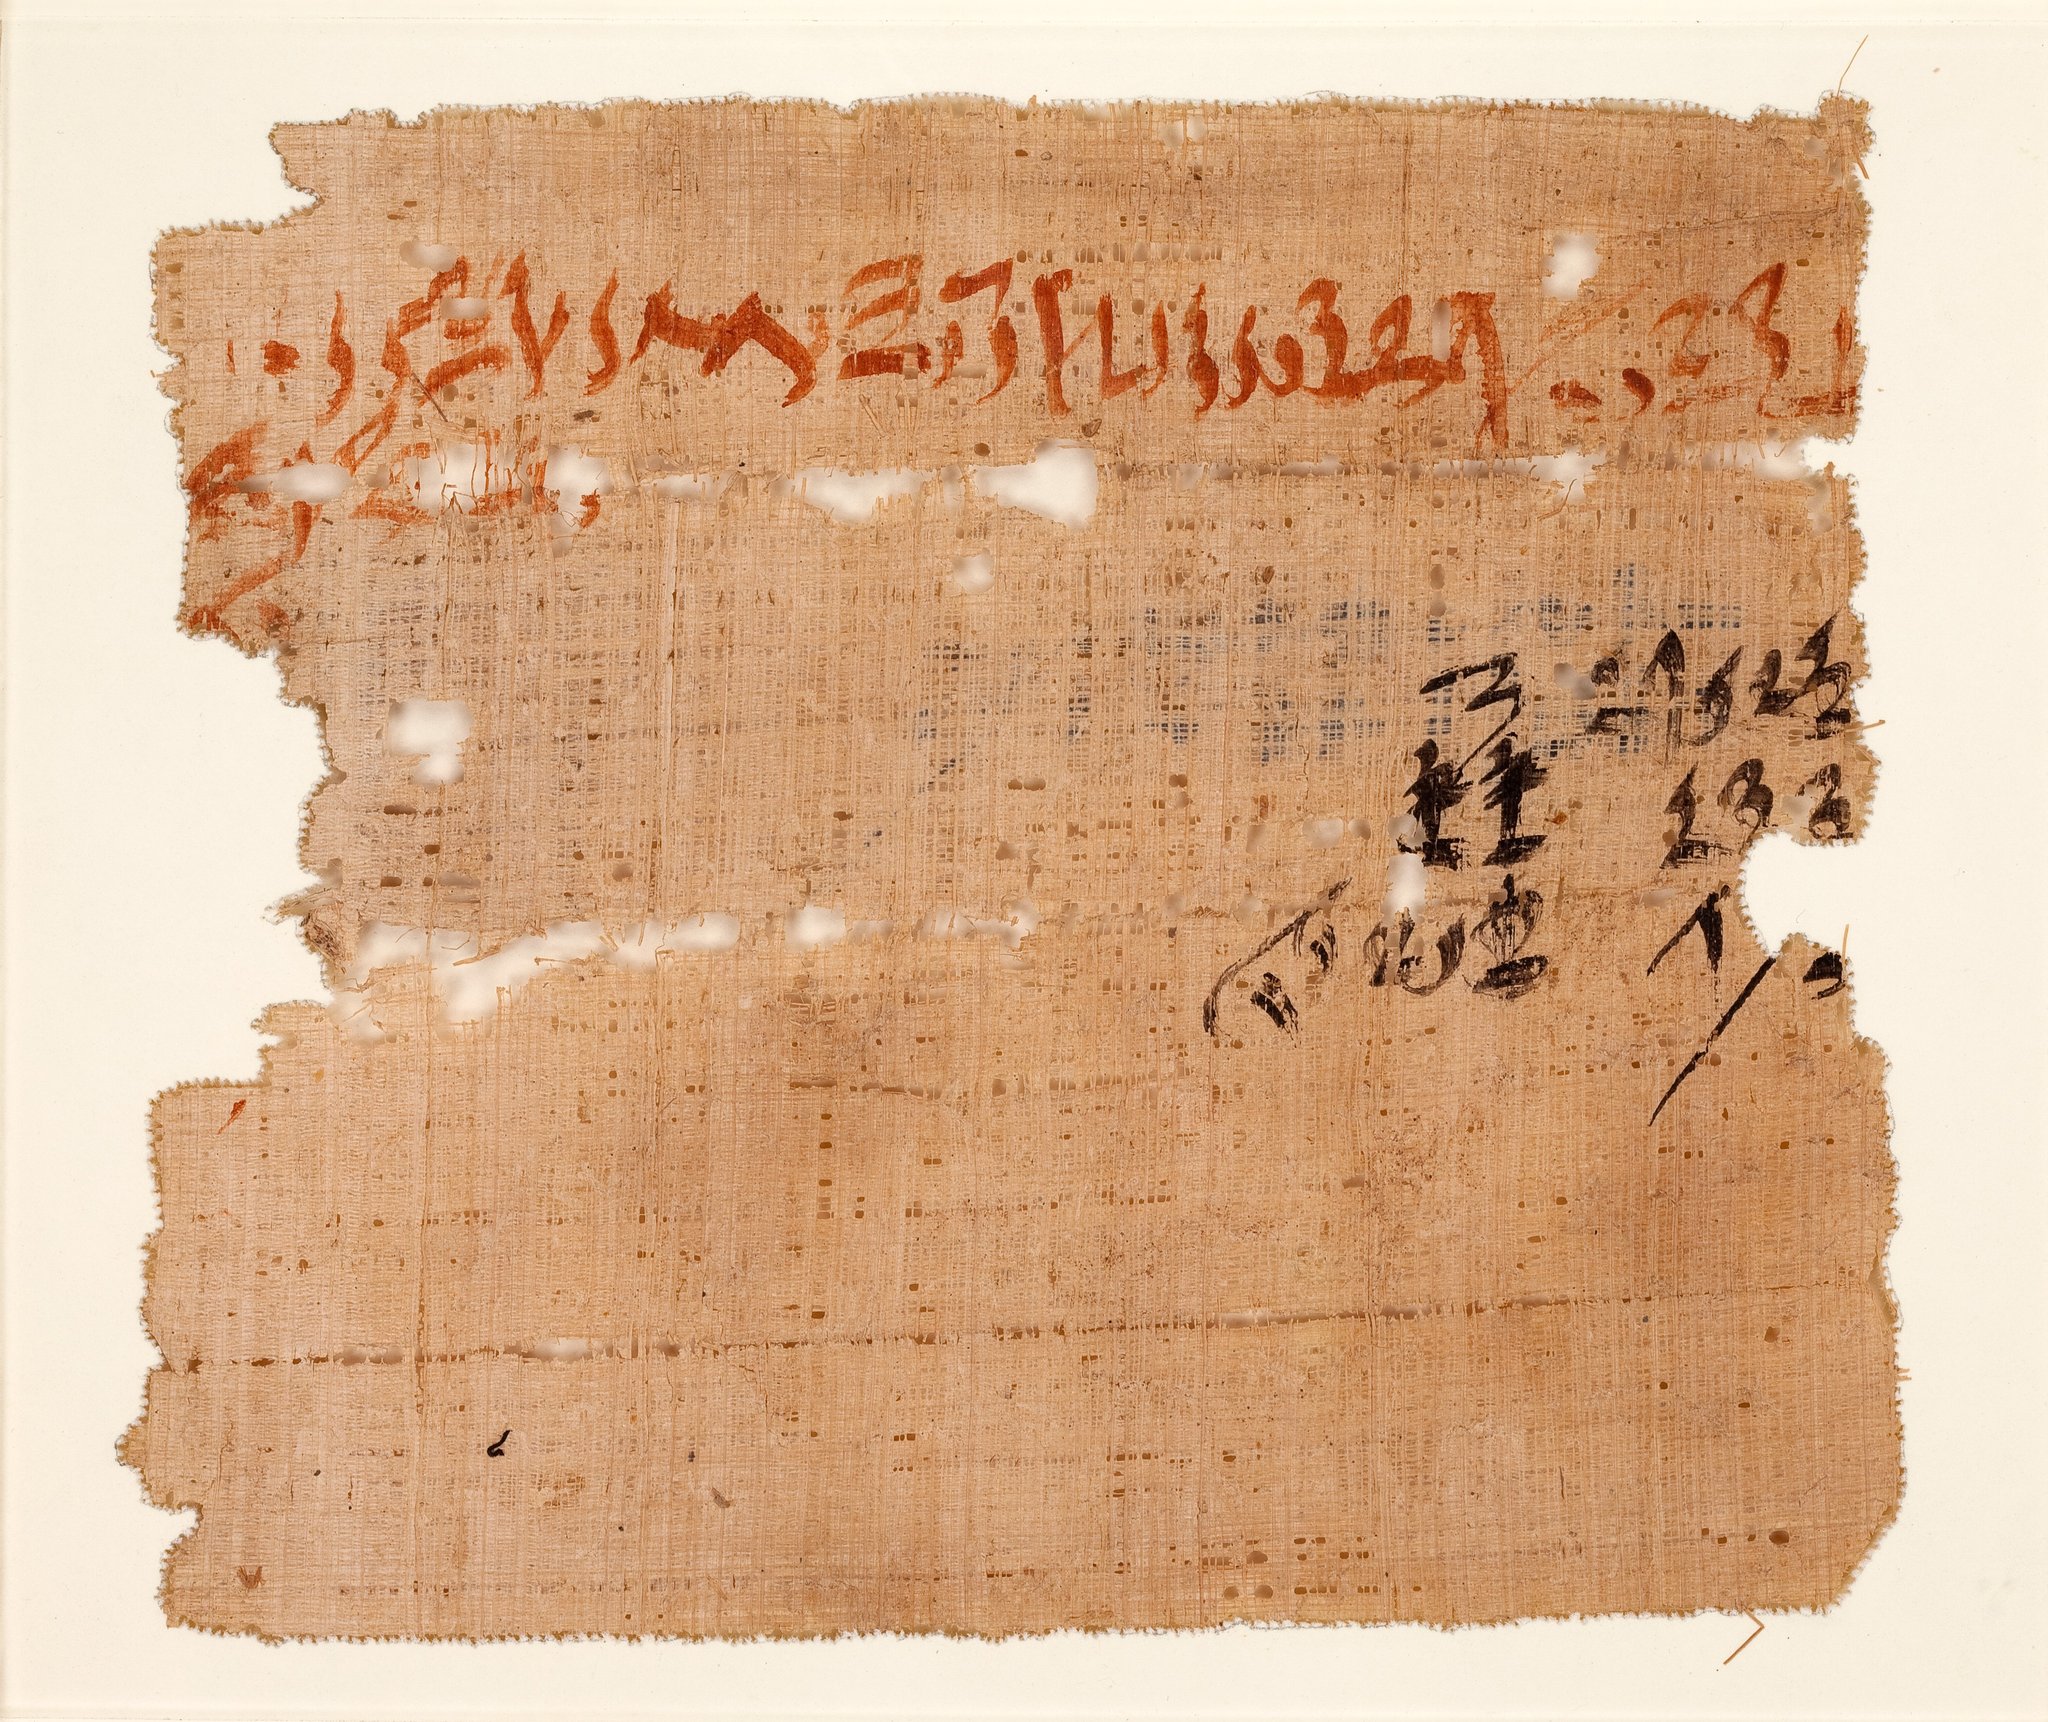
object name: papyrus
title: Two papyrus fragments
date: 2030-1640 BCE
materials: ink, papyrus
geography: egypt